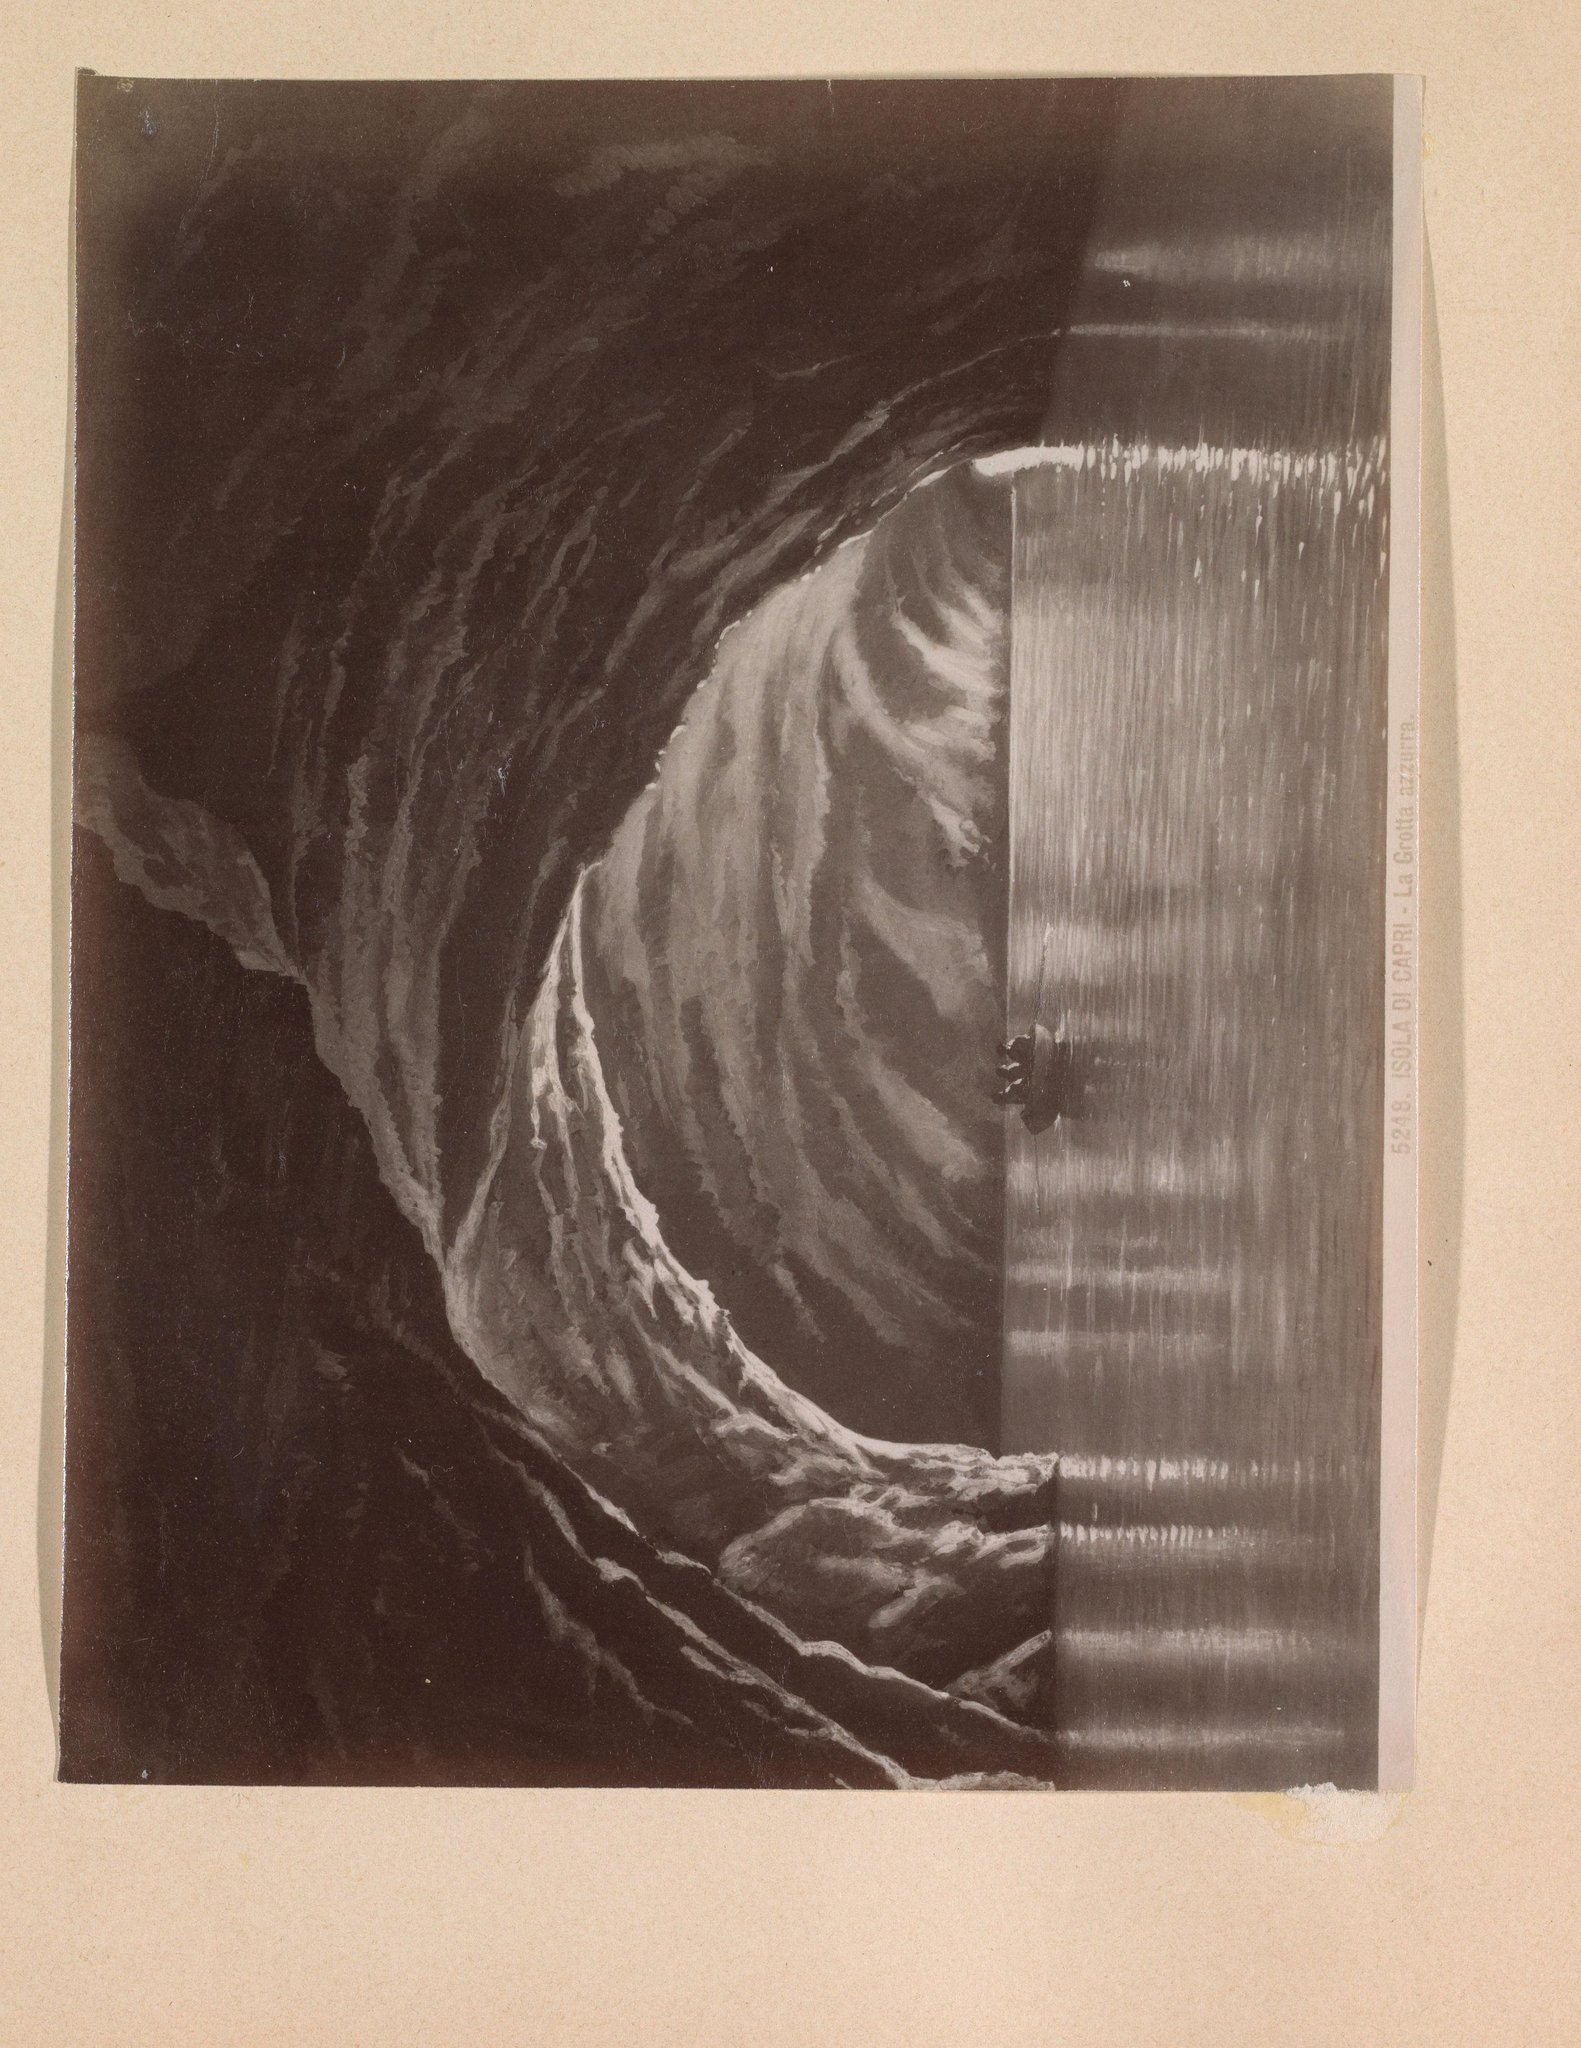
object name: photograph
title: Fotoreproductie van (vermoedelijk) een tekening van de Blauwe Grot op Capri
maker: Anonymous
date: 1870-1900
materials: paper, photographic support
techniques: albumen print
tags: cave, grotto, capri, isola di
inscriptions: negative number: ‘5248’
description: Onderdeel van Reisalbum met foto's van bezienswaardigheden in Italië en Zuid-Frankrijk.